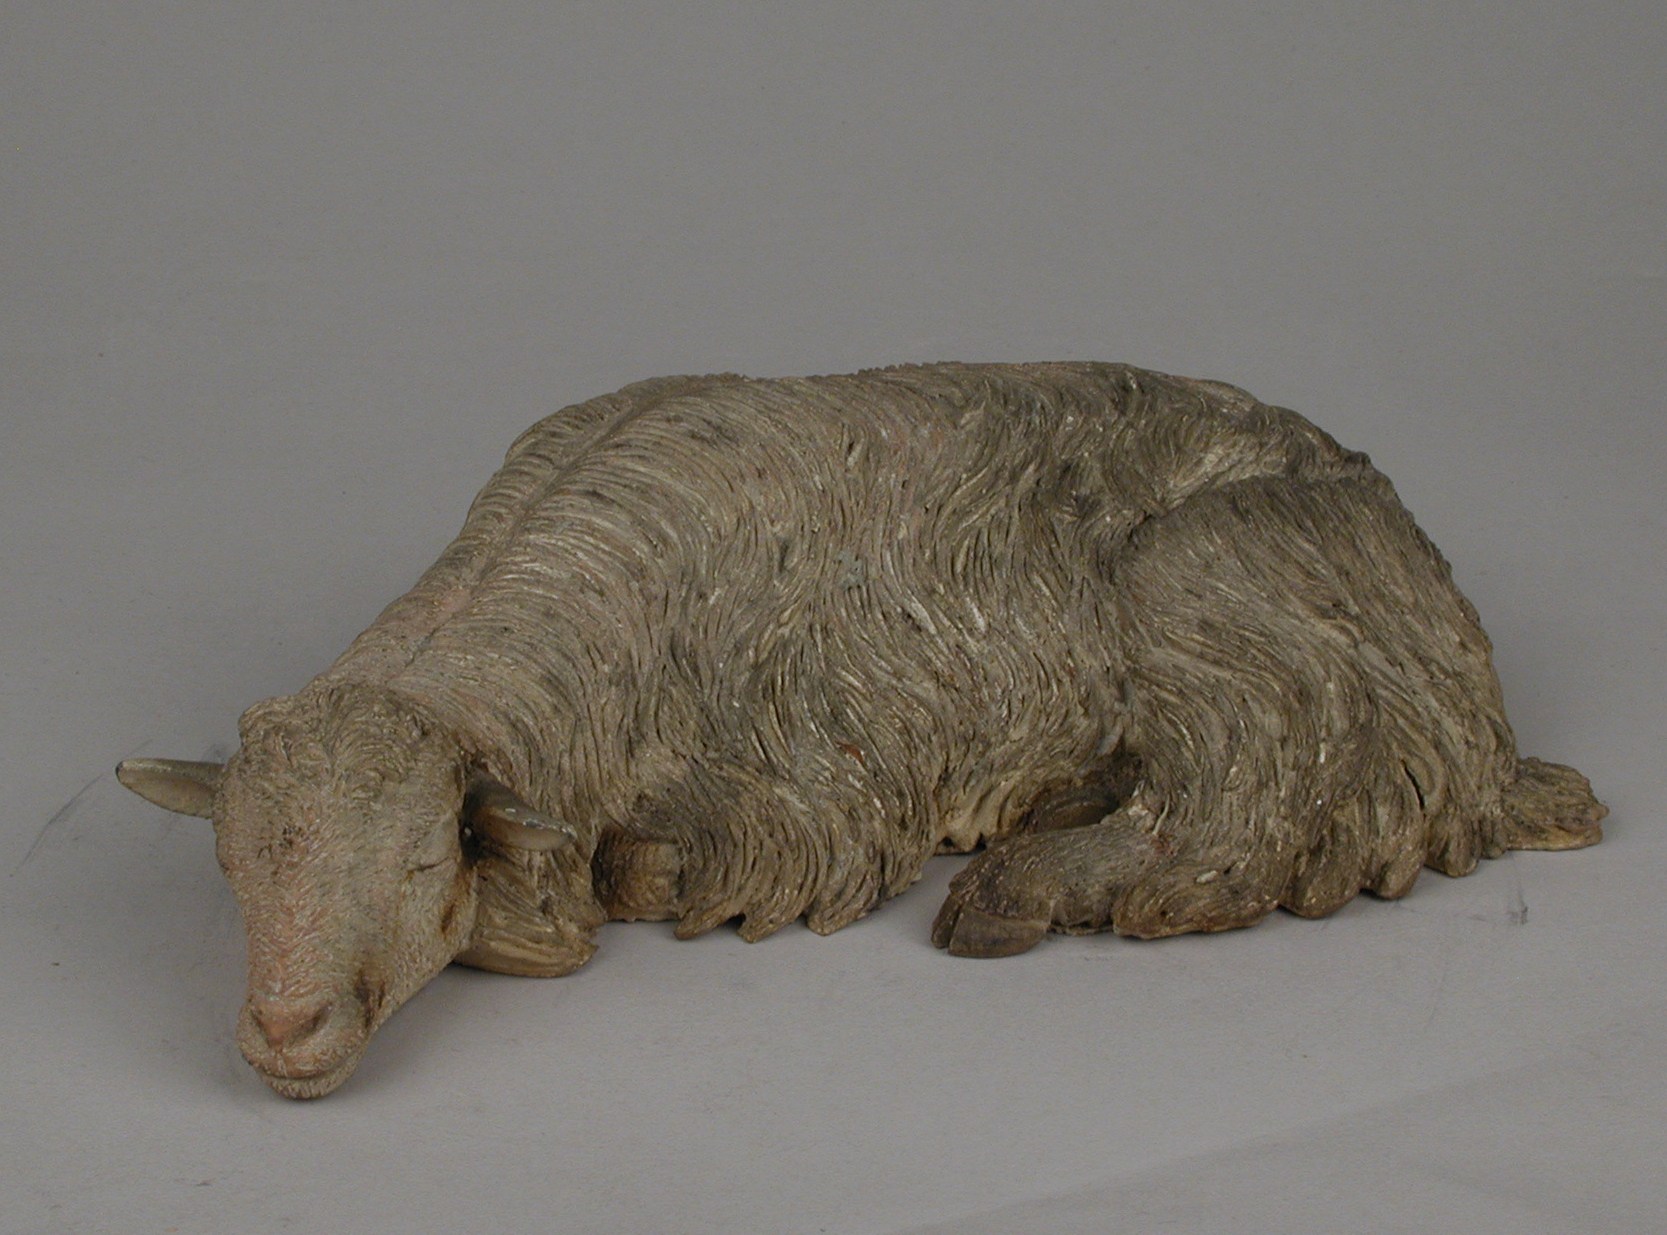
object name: crèche figure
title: Sleeping sheep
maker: francesco gallo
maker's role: maker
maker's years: 1700-1800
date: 1701-1900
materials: metal, terracotta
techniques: polychrome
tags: sheep